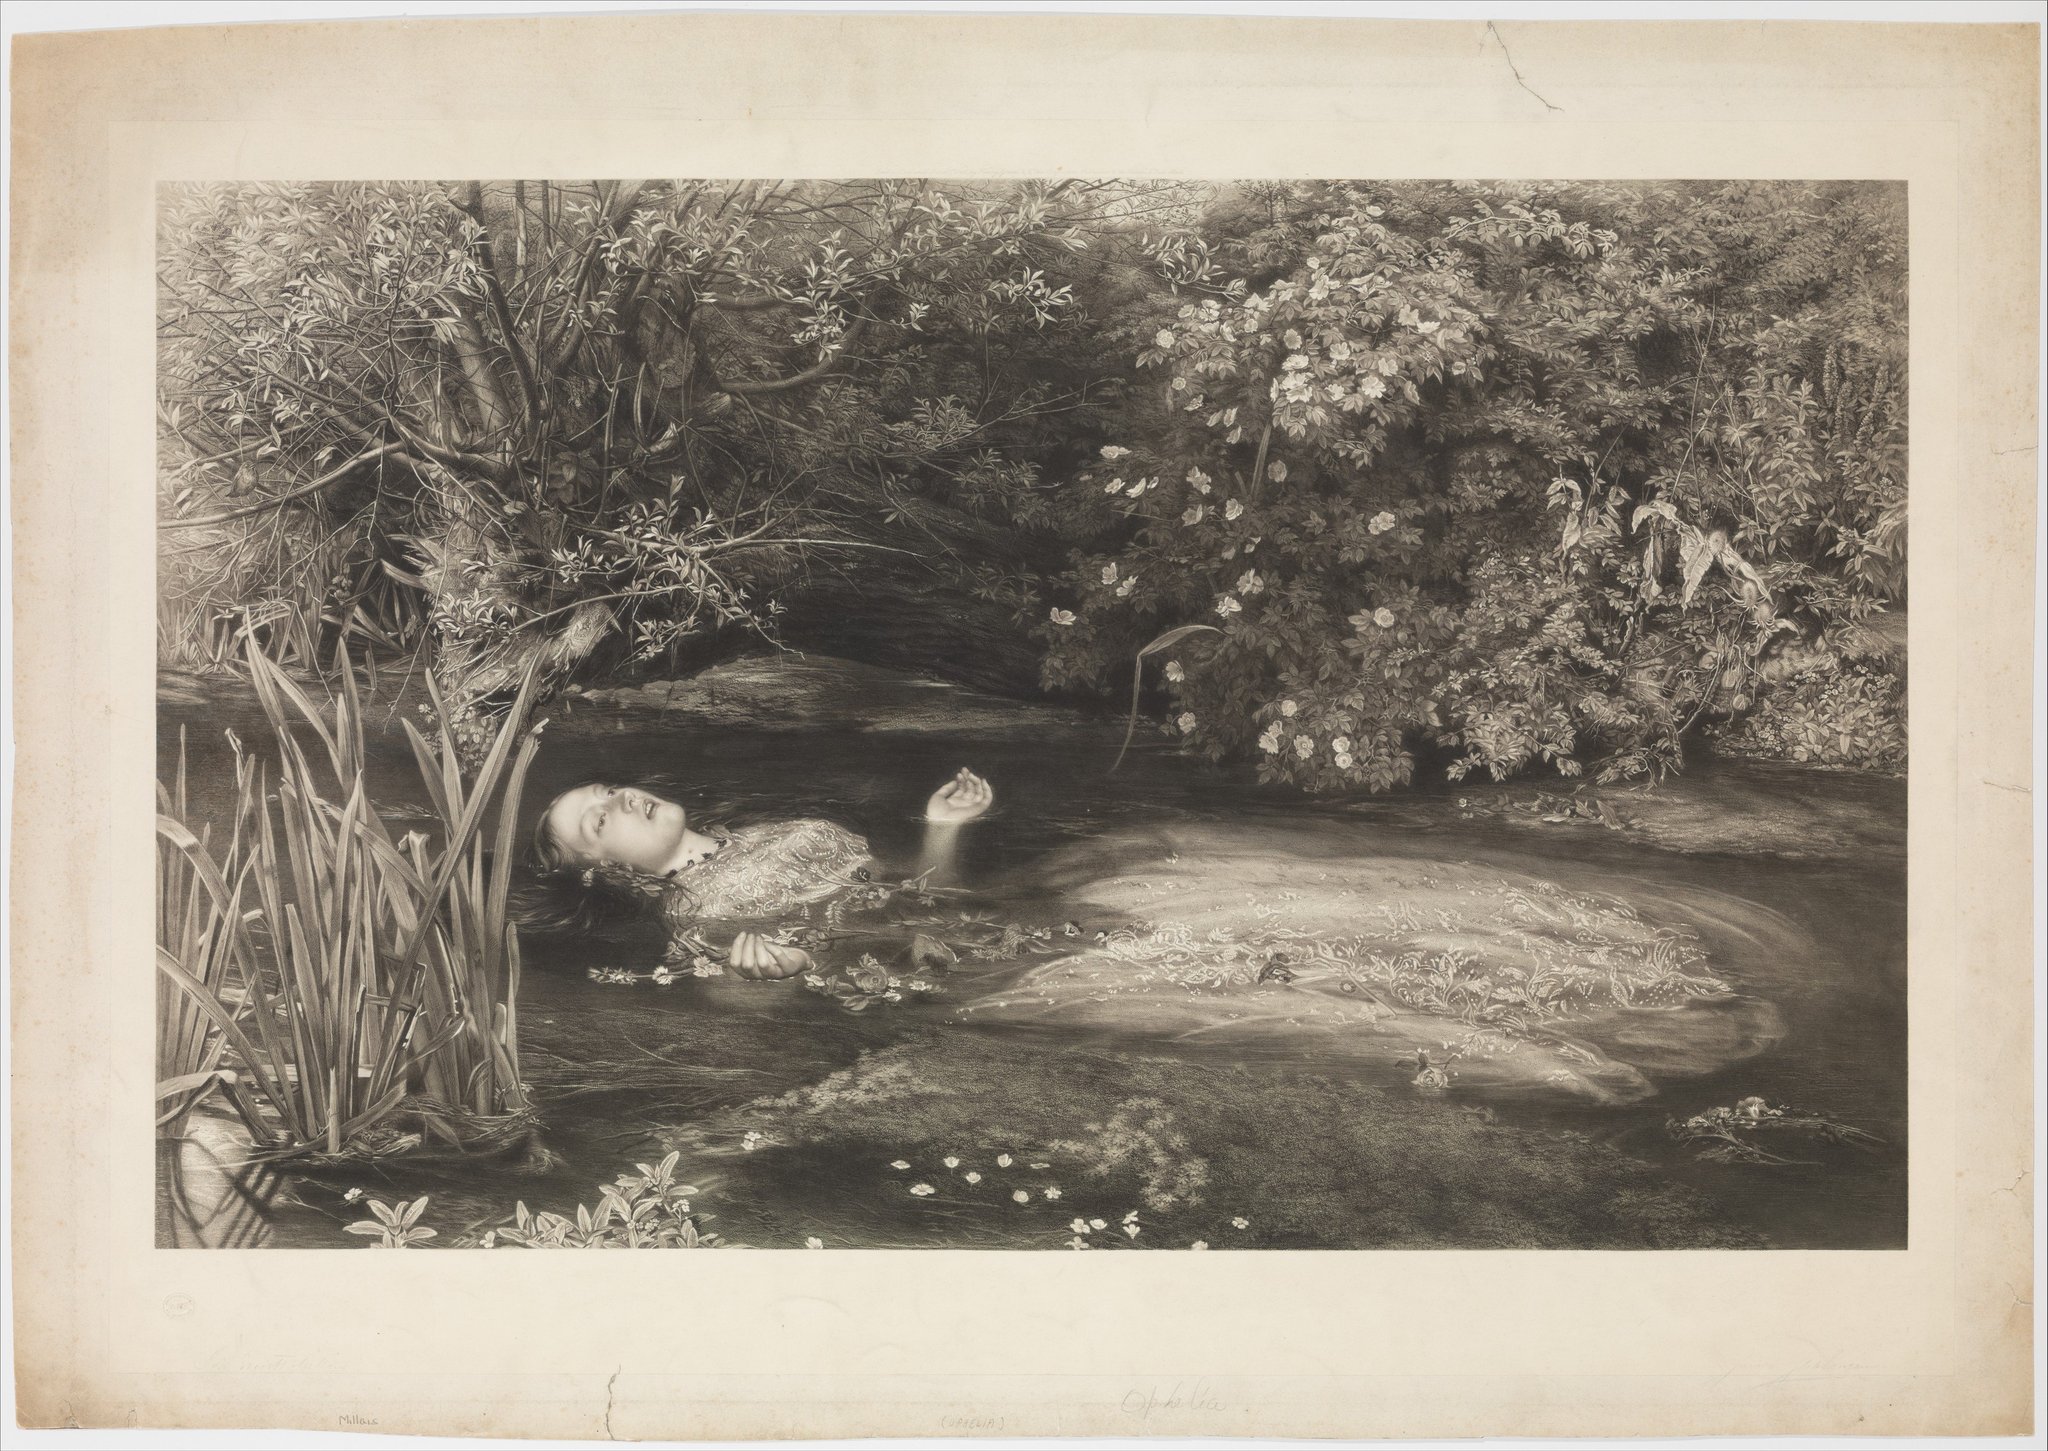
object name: print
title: Ophelia (Shakespeare, Hamlet, Act 4, Scene 7)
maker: sir john everett millais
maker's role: artist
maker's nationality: british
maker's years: 1829-1896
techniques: printmaking, etching, mezzotint, stippling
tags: shakespeare,women,death,hamlet